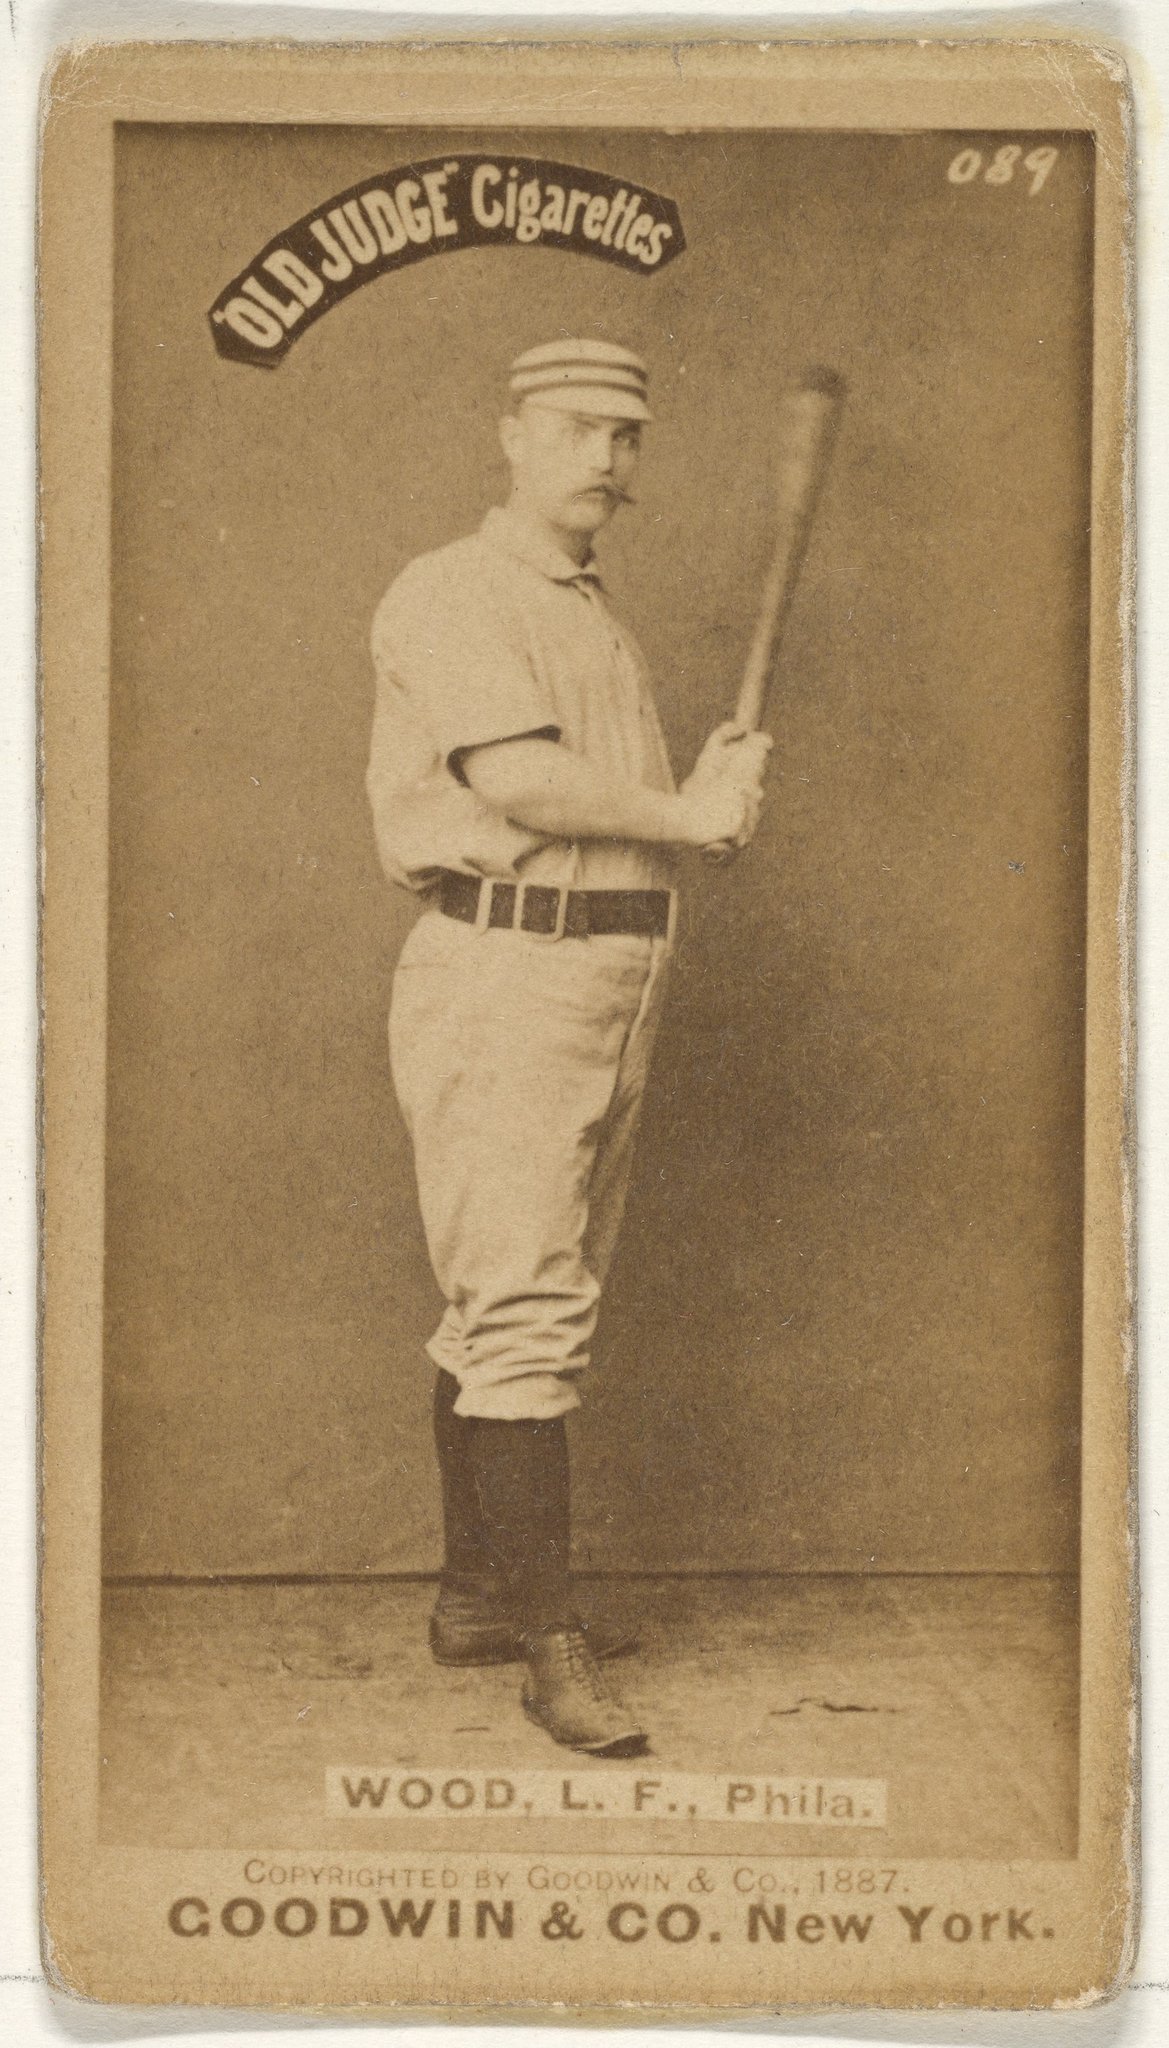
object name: baseball card, photograph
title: George A. Wood, Left Field, Philadelphia, from the Old Judge series (N172) for Old Judge Cigarettes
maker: goodwin & company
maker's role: publisher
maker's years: 1850-1950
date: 1887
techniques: albumen silver print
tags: men,portraits,baseball,athletes